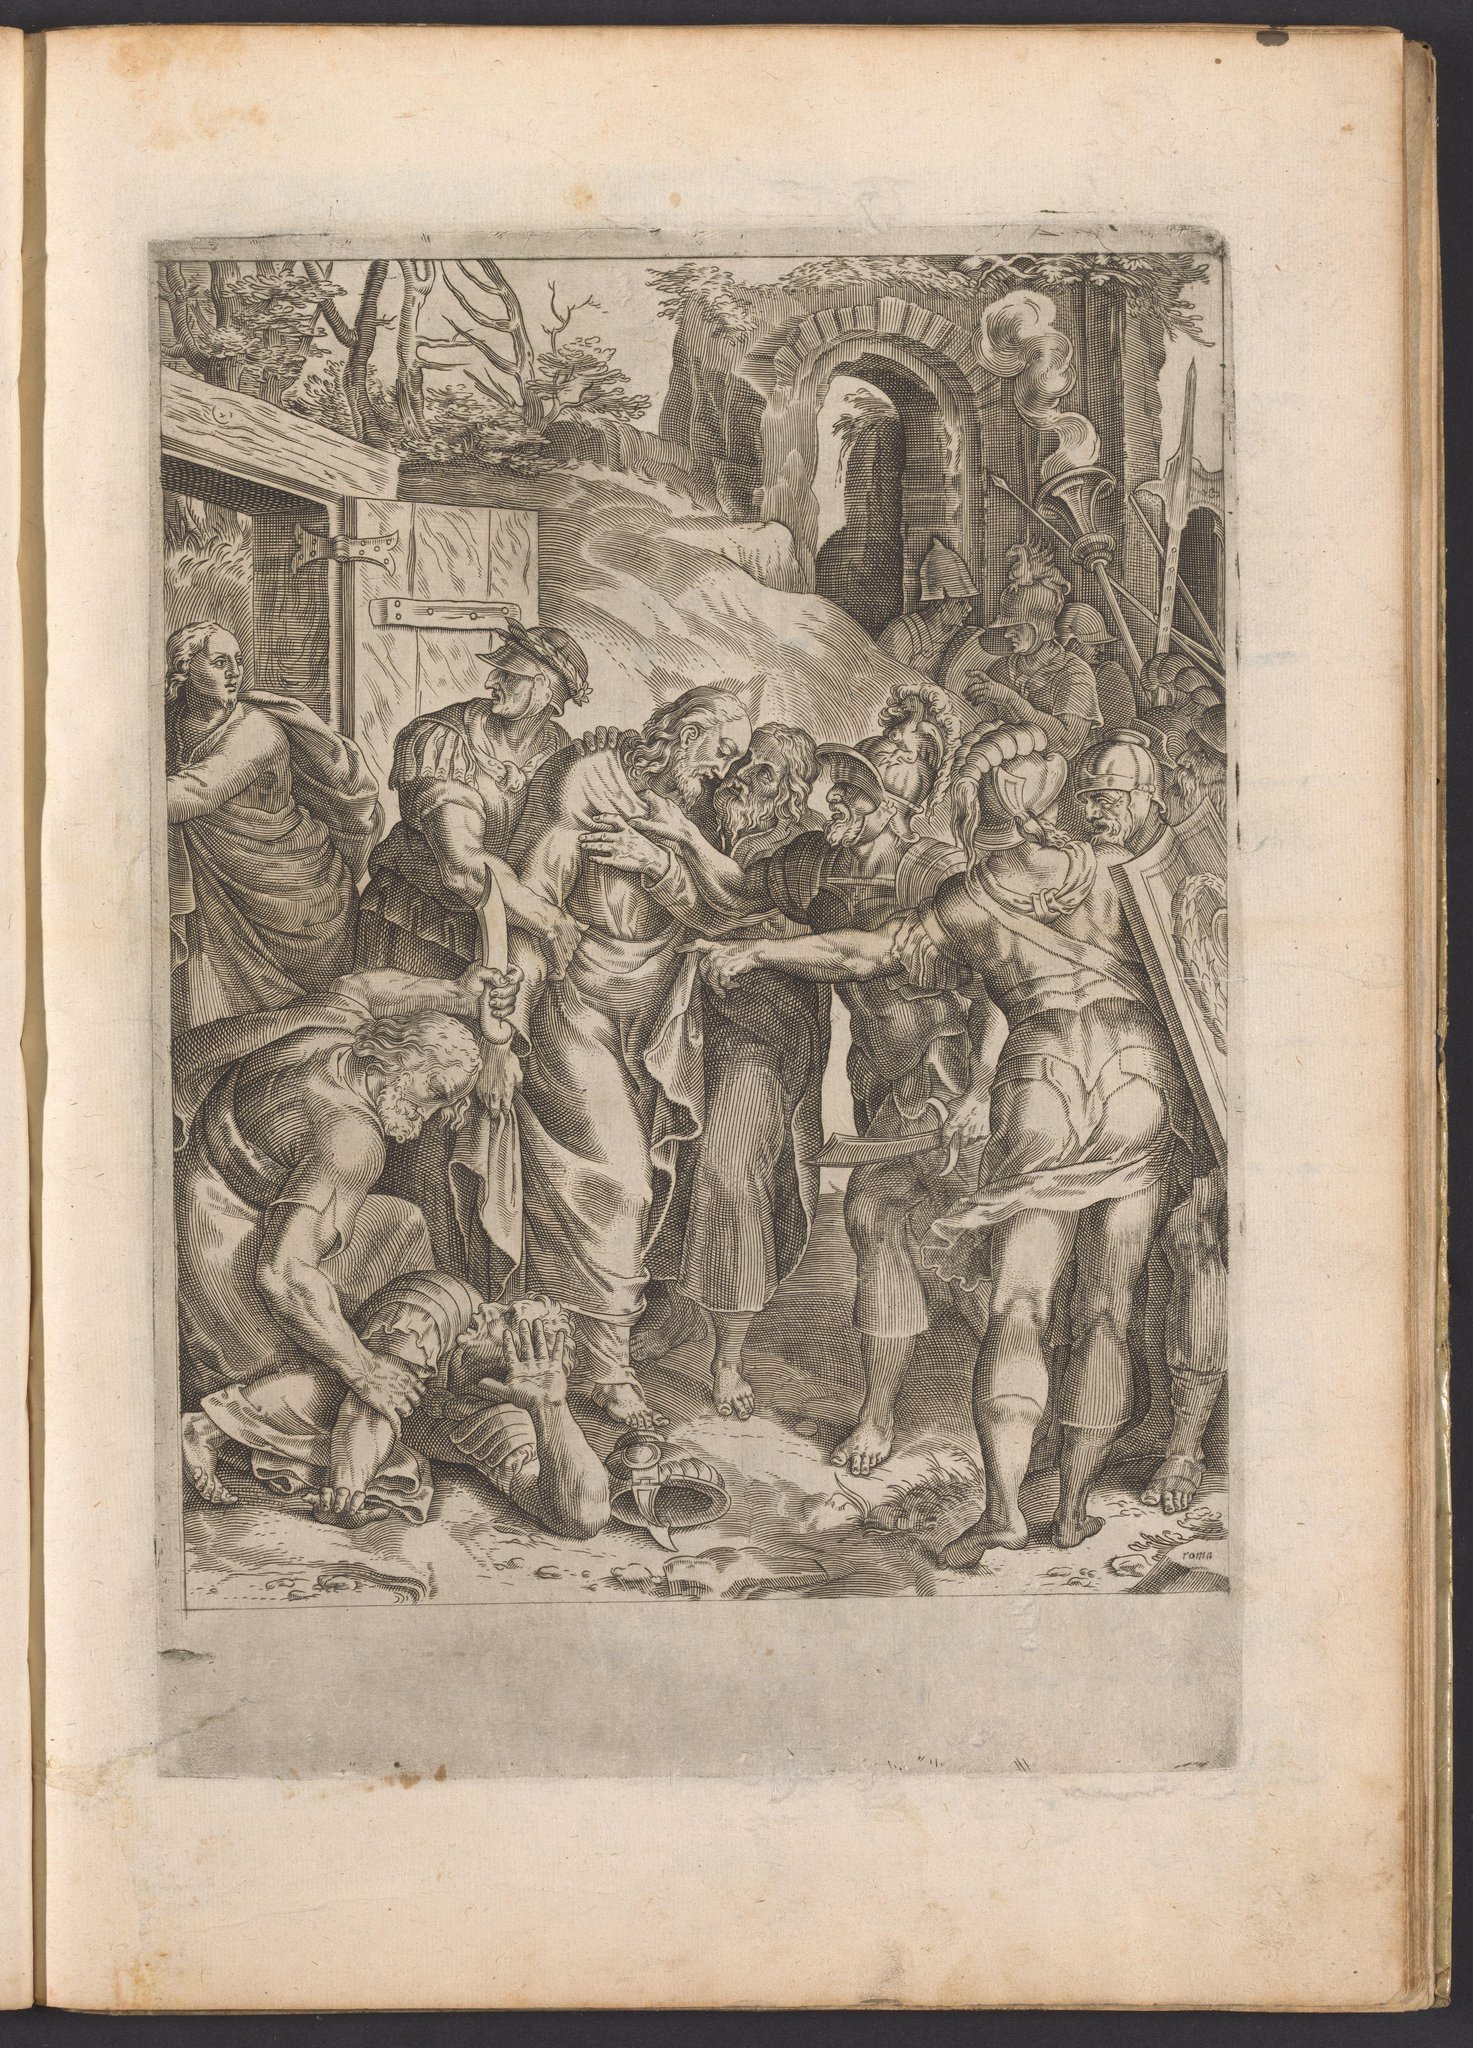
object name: album leaf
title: Verraad van Christus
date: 1570-1573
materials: paper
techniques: engraving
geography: rome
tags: judas iscariot is revealed as christ's betrayer (communion of judas)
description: Deze prent maakt deel uit van een album.